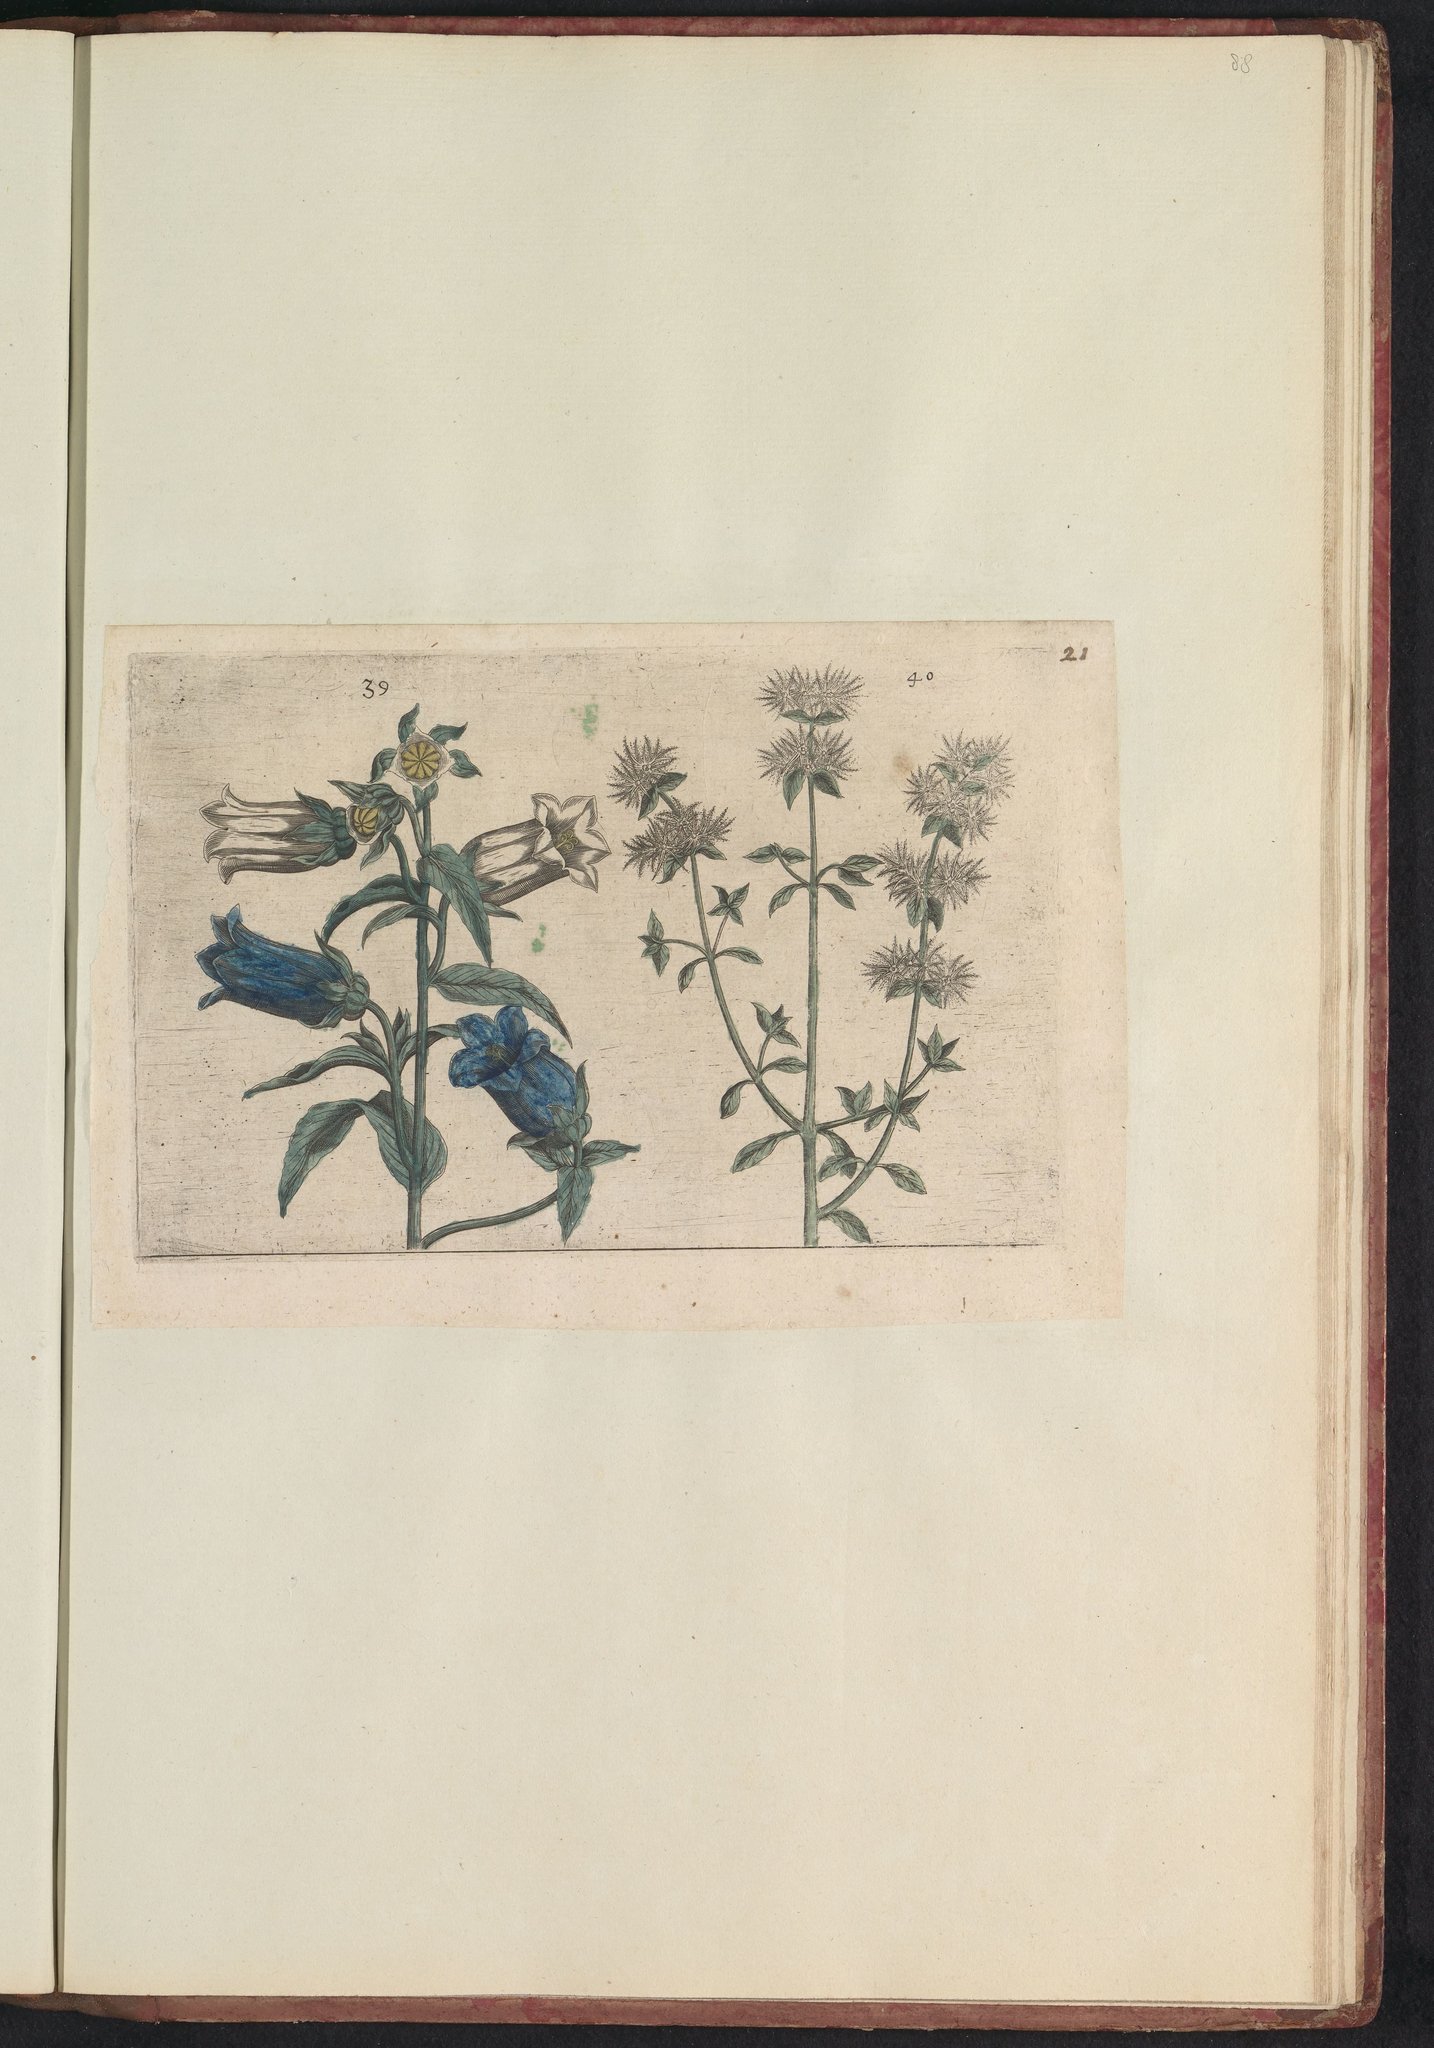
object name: print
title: Mariëtteklokje (Campanula medium) en marjolein (Thymus mastichina)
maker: Anonymous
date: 1604-1632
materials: ink, paper, watercolor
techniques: engraving, hand coloring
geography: cologne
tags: flowers: campanula, plants and herbs: marjoram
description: Mariëtteklokje en marjolein of thijm. Figs. 39 en 40 op een blad met de hand genummerd 21. In: Anselmi Boëtii de Boot I.C. Brugensis & Rodolphi II. Imp. Roman. medici a cubiculis Florum, Herbarum, ac fructuum selectiorum icones, & vires pleraeque hactenus ignotæ. Onderdeel van het album met bladen en platen uit De Boodts herbarium van 1640. Het twaalfde van twaalf albums met aquarellen van dieren, vogels en planten bekend rond 1600, gemaakt in opdracht van keizer Rudolf II.